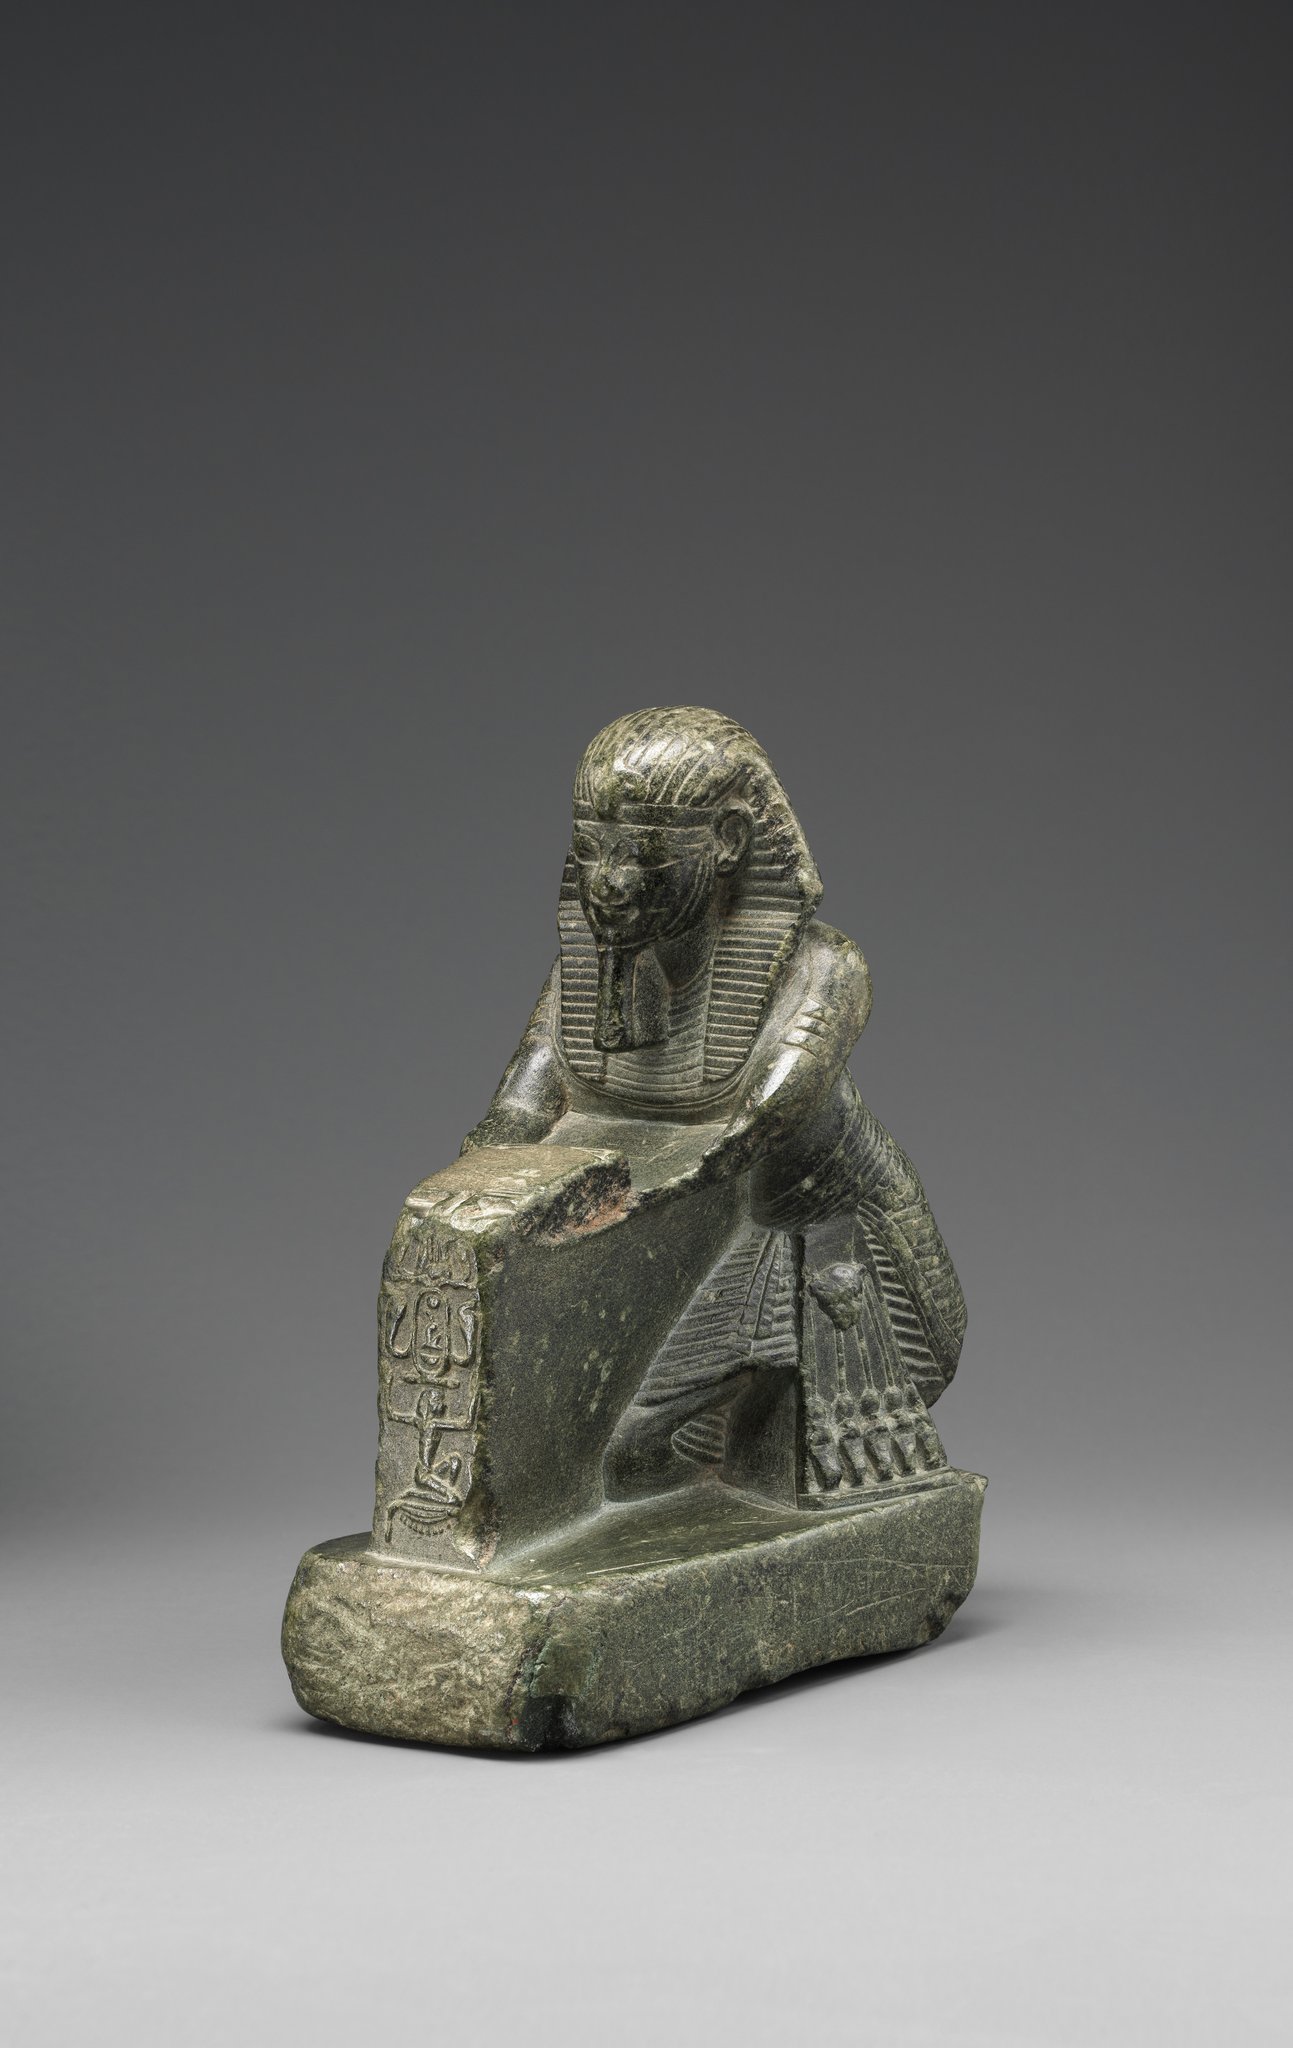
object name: statuette, amenhotep iii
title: Statuette of Amenhotep III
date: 1390-1352 BCE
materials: mineral, stone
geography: egypt